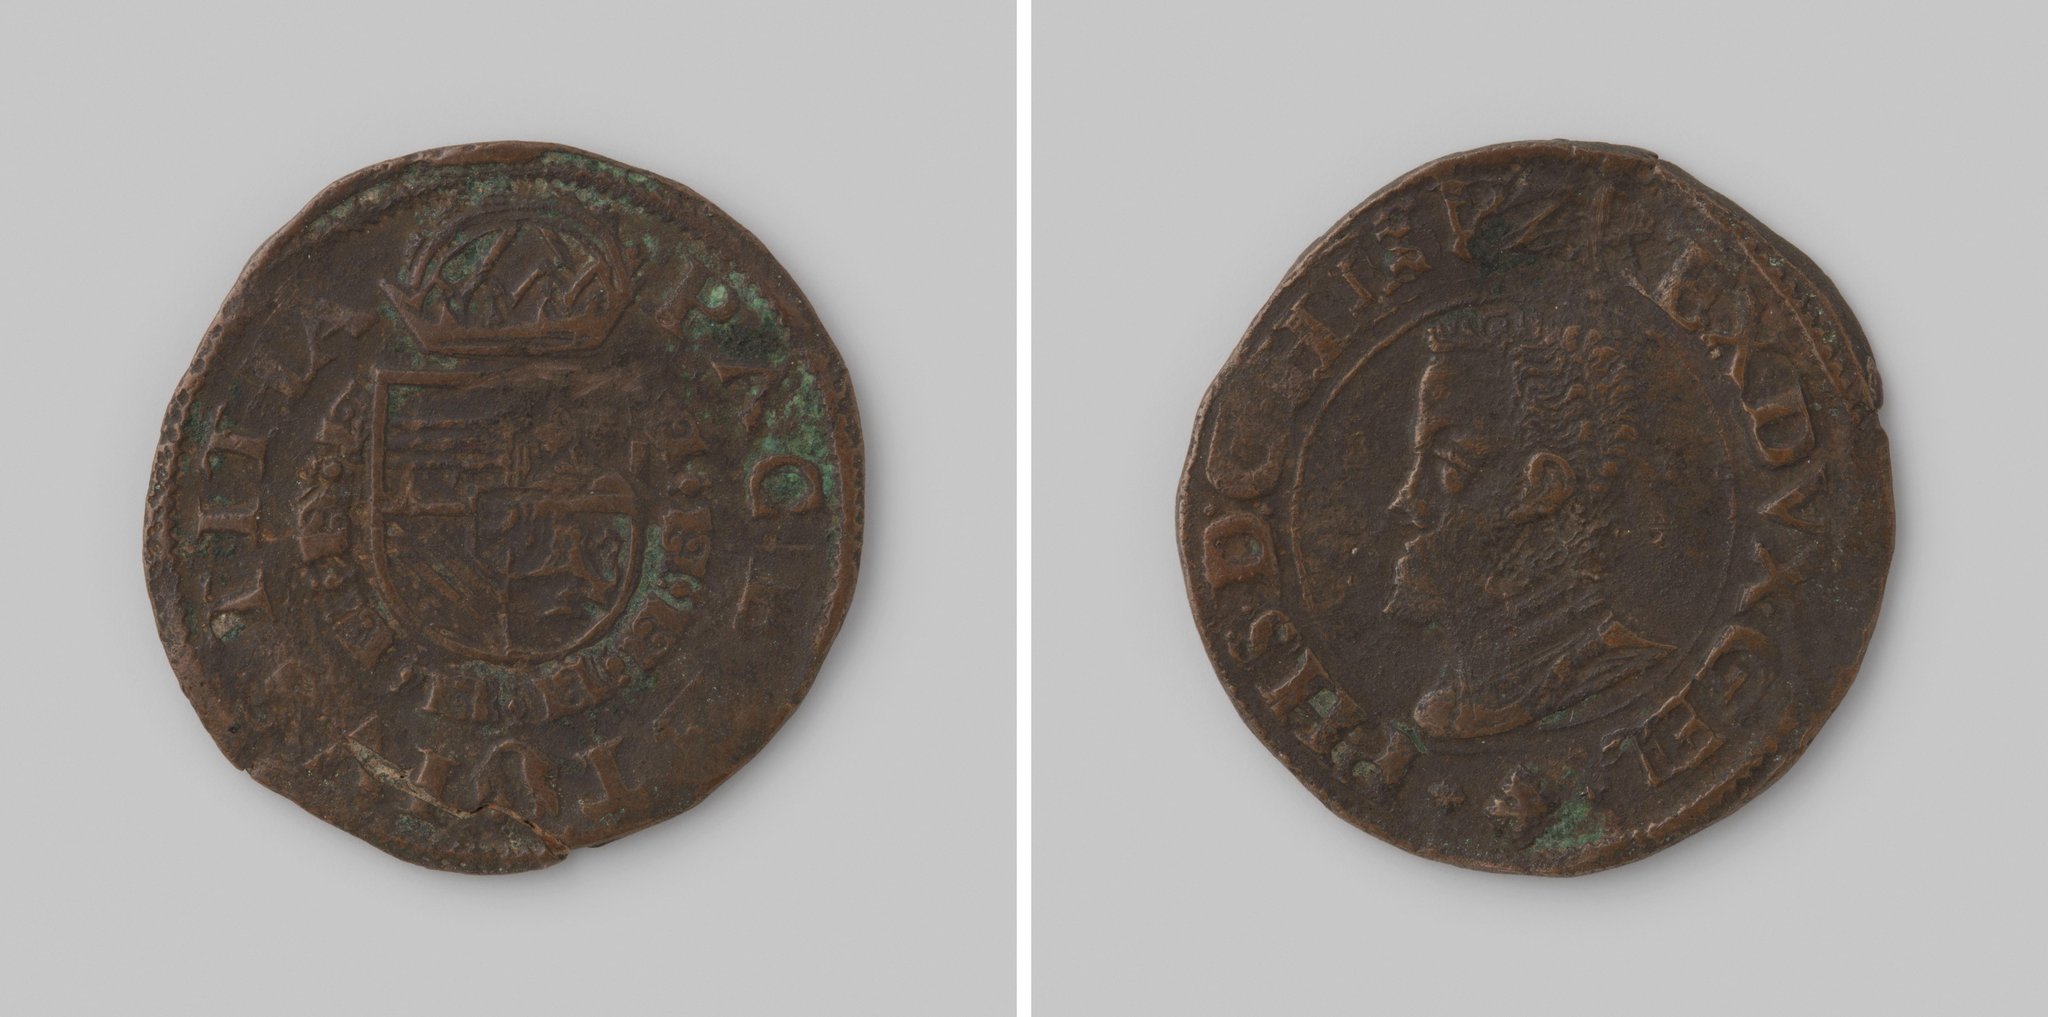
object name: coin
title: Gelderland, Philips II, statenoord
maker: philip ii of spain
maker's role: koning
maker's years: 1527-1598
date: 1577-1578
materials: copper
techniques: striking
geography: gelderland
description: Koperen munt. Voorzijde: gekroond Bourgondisch wapenschild, waaromheen keten van het Gulden Vlies. Keerzijde: portret Philips II naar links.